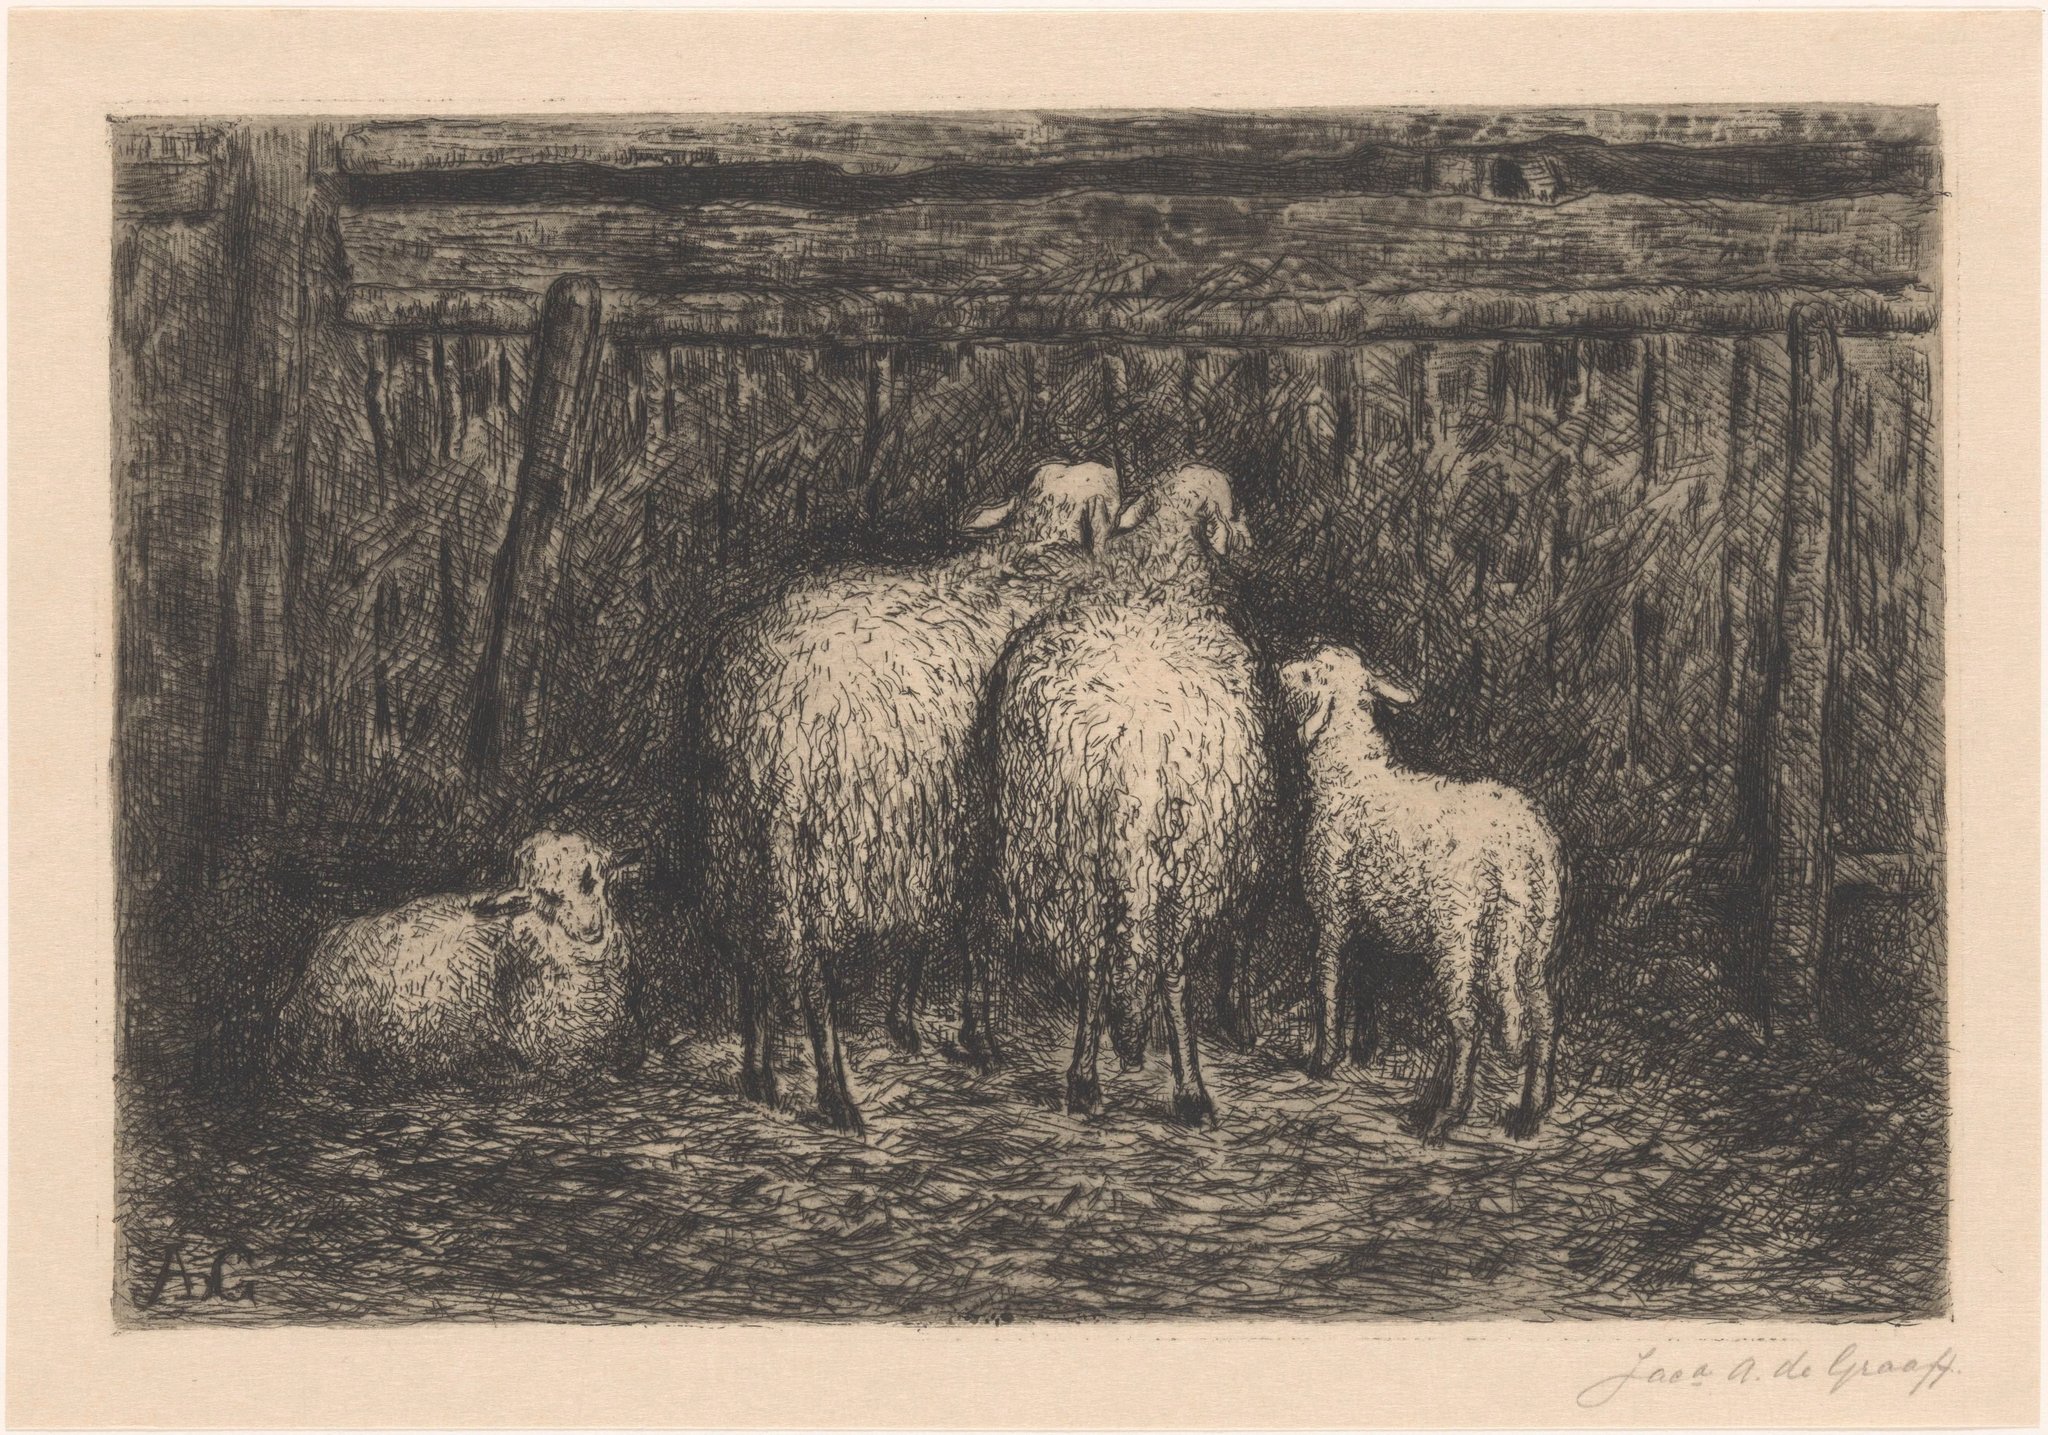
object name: print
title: Schapen in een stal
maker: jacoba de graaff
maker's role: print maker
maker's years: 1857-1940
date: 1867-1911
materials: paper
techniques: etching, intaglio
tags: sheep, stall, stable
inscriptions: collector's mark: Lugt 2228